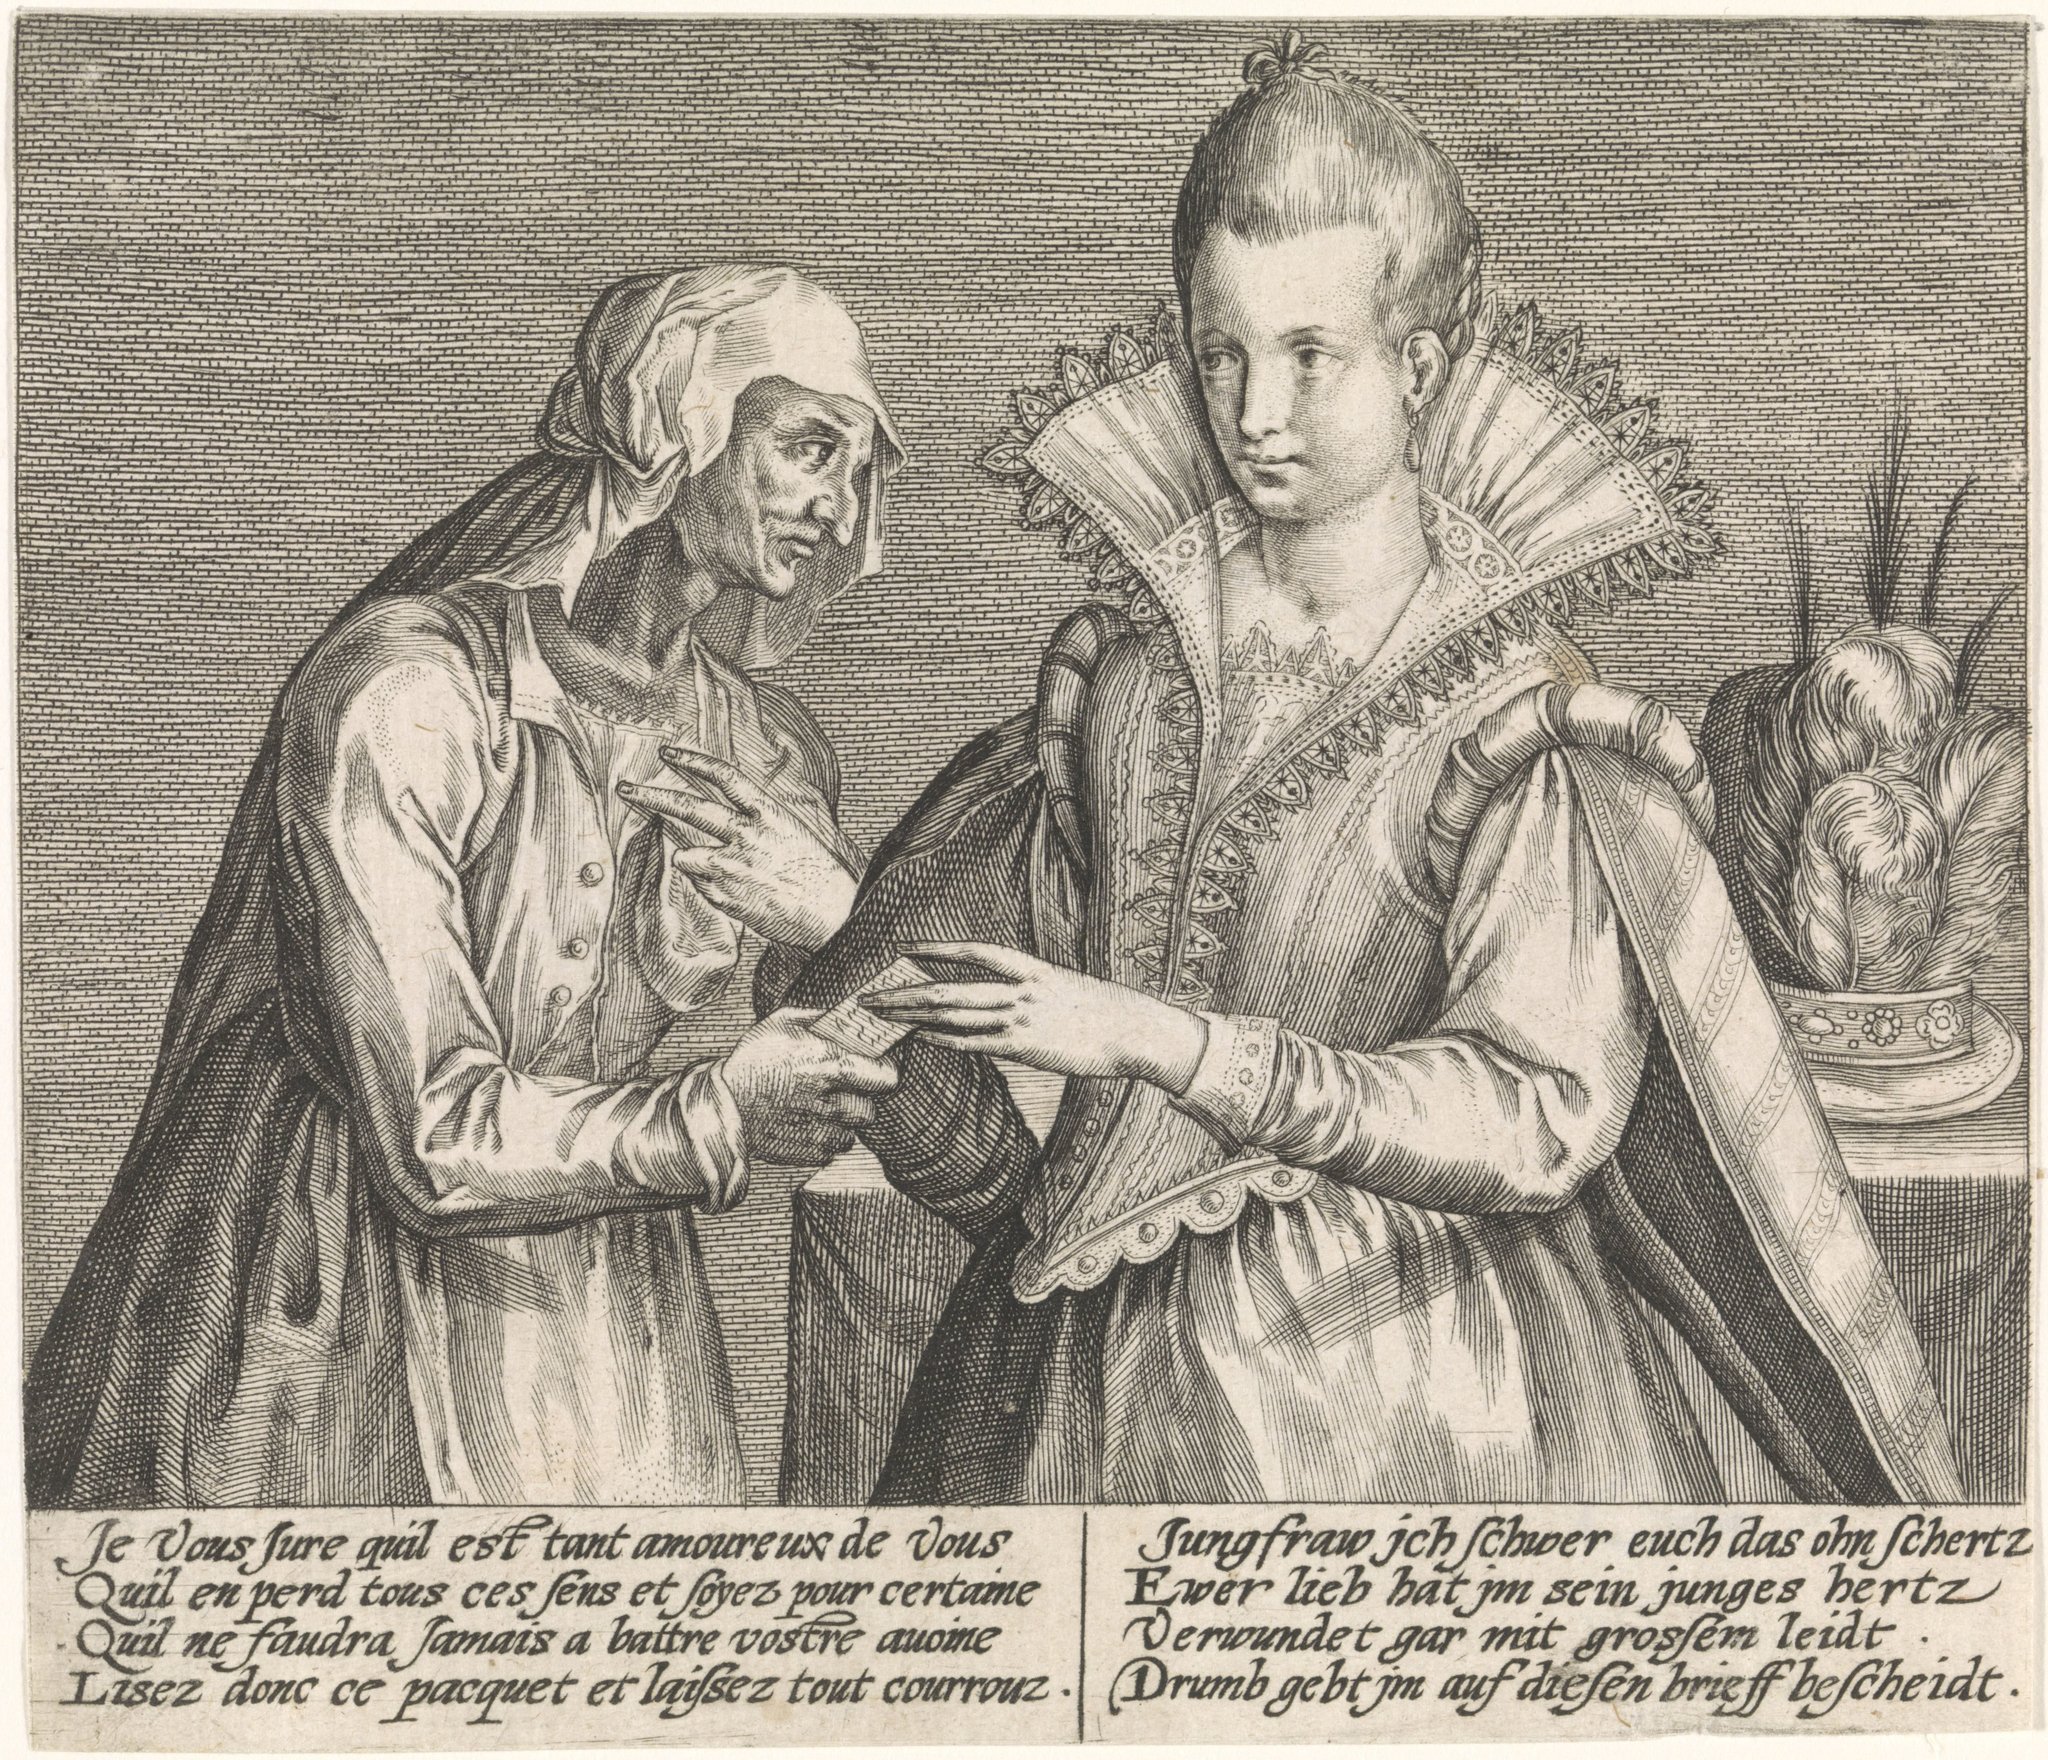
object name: print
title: Oude vrouw overhandigt brief aan jonge vrouw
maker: crispijn van de passe (i)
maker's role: draughtsman, print maker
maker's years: 1564-1637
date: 1574-1637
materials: paper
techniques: engraving, etching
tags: marriage broker, lover with love-letter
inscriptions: collector's mark: Lugt 2161, collector's mark: Lugt 2228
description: Een oude koppelaarster overhandigt een jonge elegant geklede vrouw een brief van een minnaar. In de marge een vierregelig onderschrift in het Frans en in het Duits.